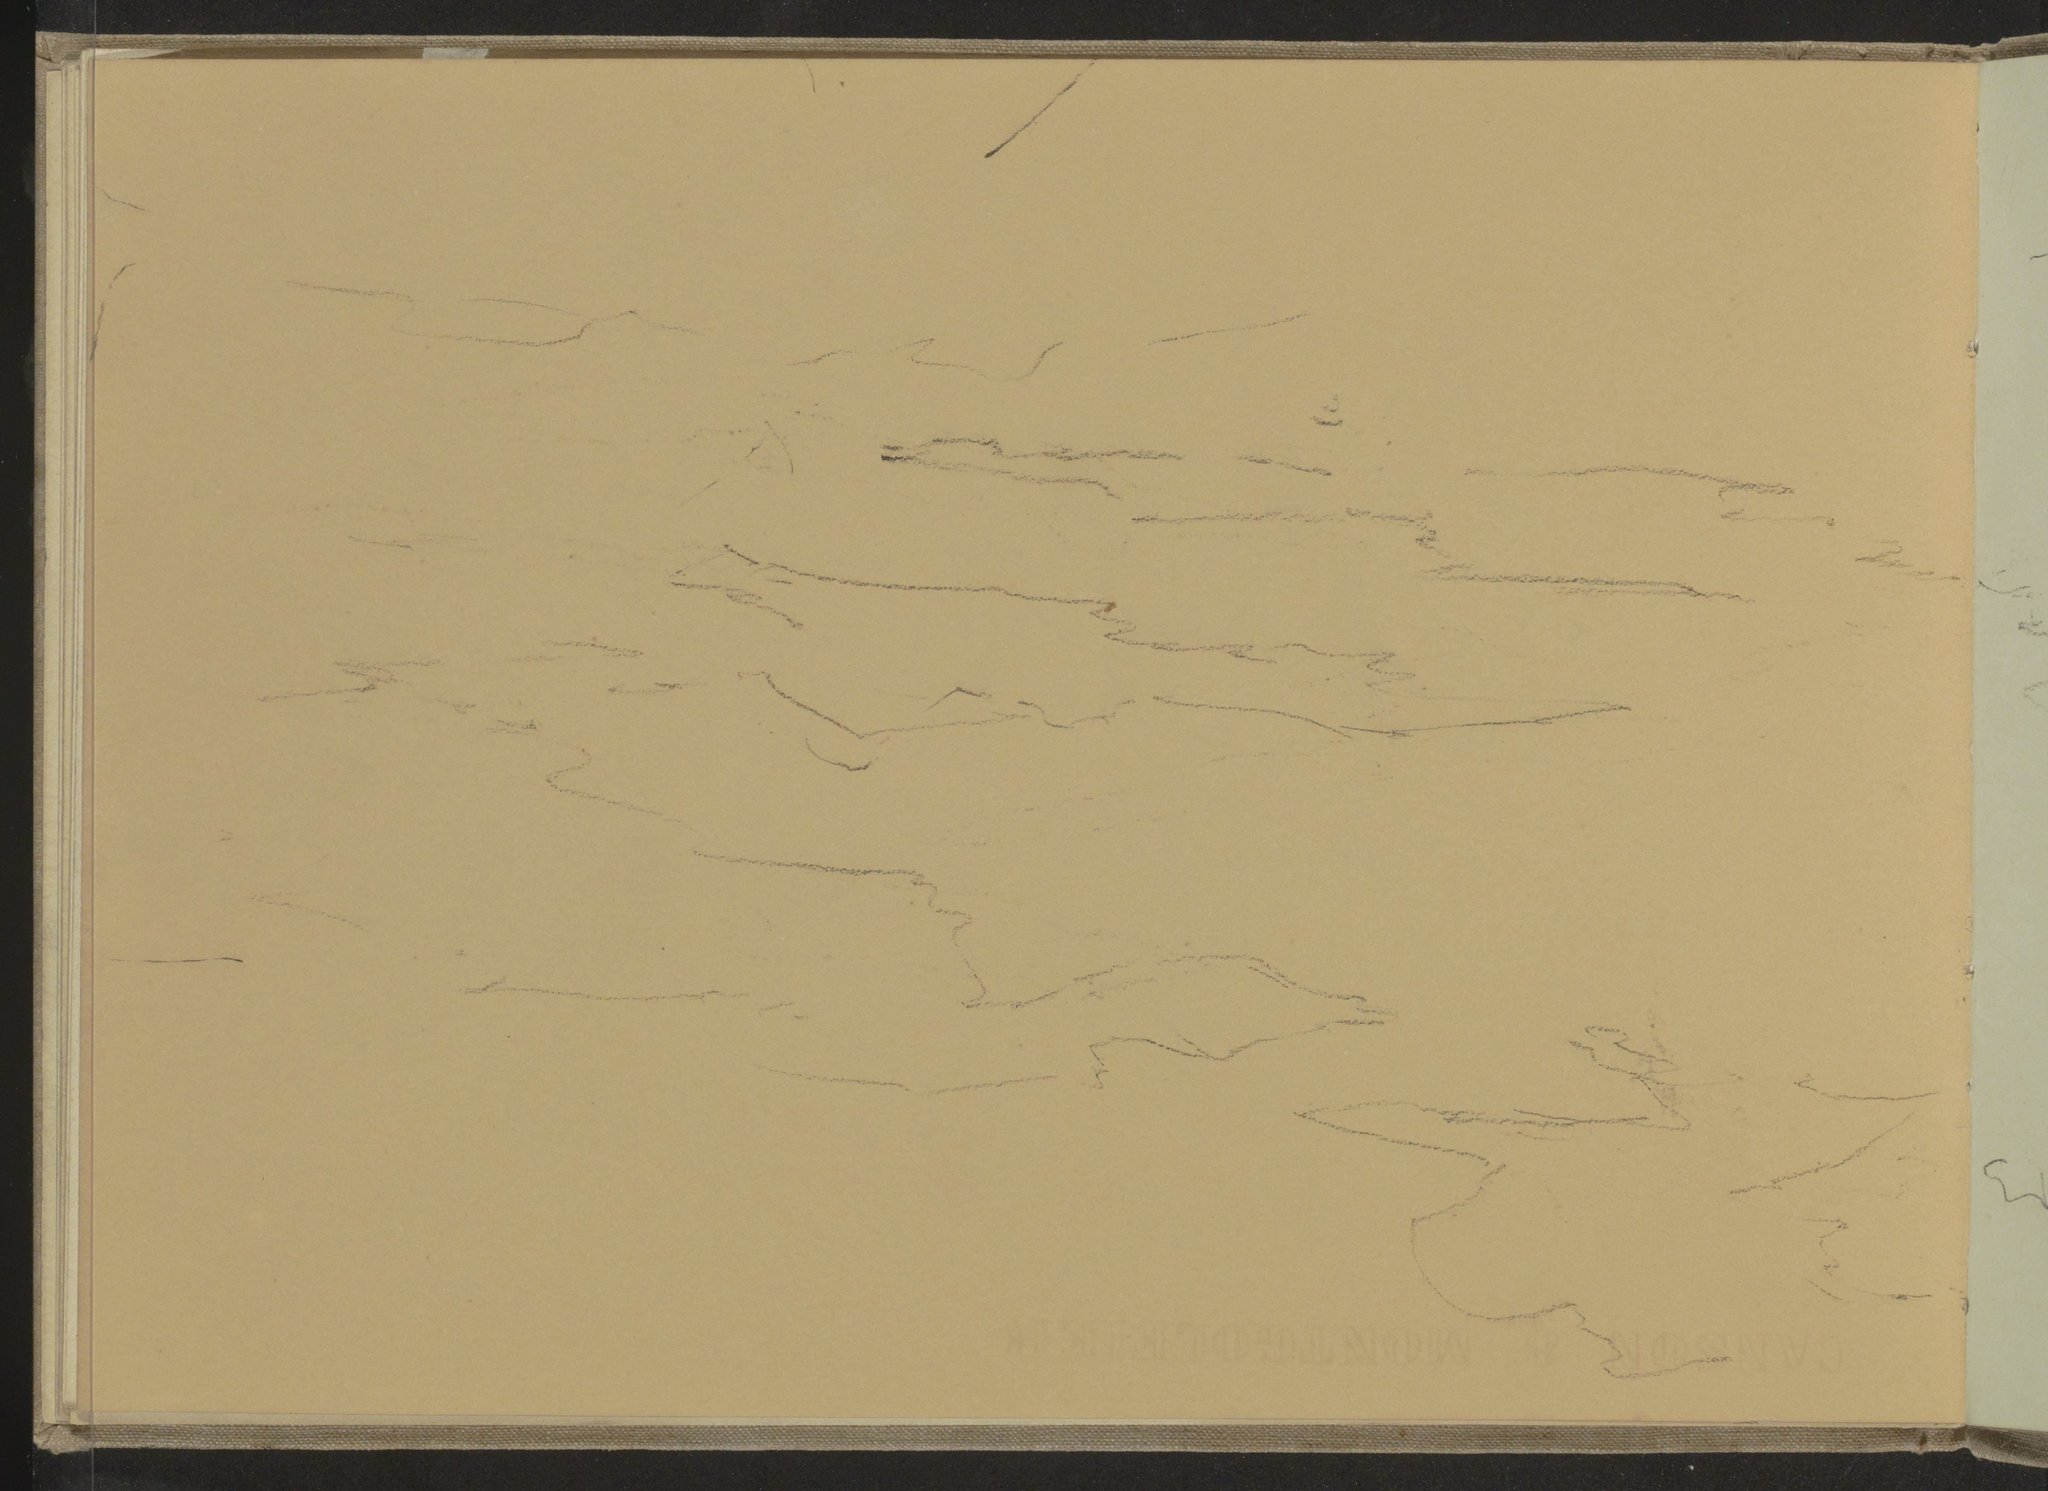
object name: sketchbook leaf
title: Wolken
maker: jozef israëls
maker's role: draughtsman, painter, print maker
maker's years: 1824-1911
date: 1834-1911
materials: chalk, paper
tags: clouds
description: Blad 22 verso uit een schetsboek met 27 bladen.